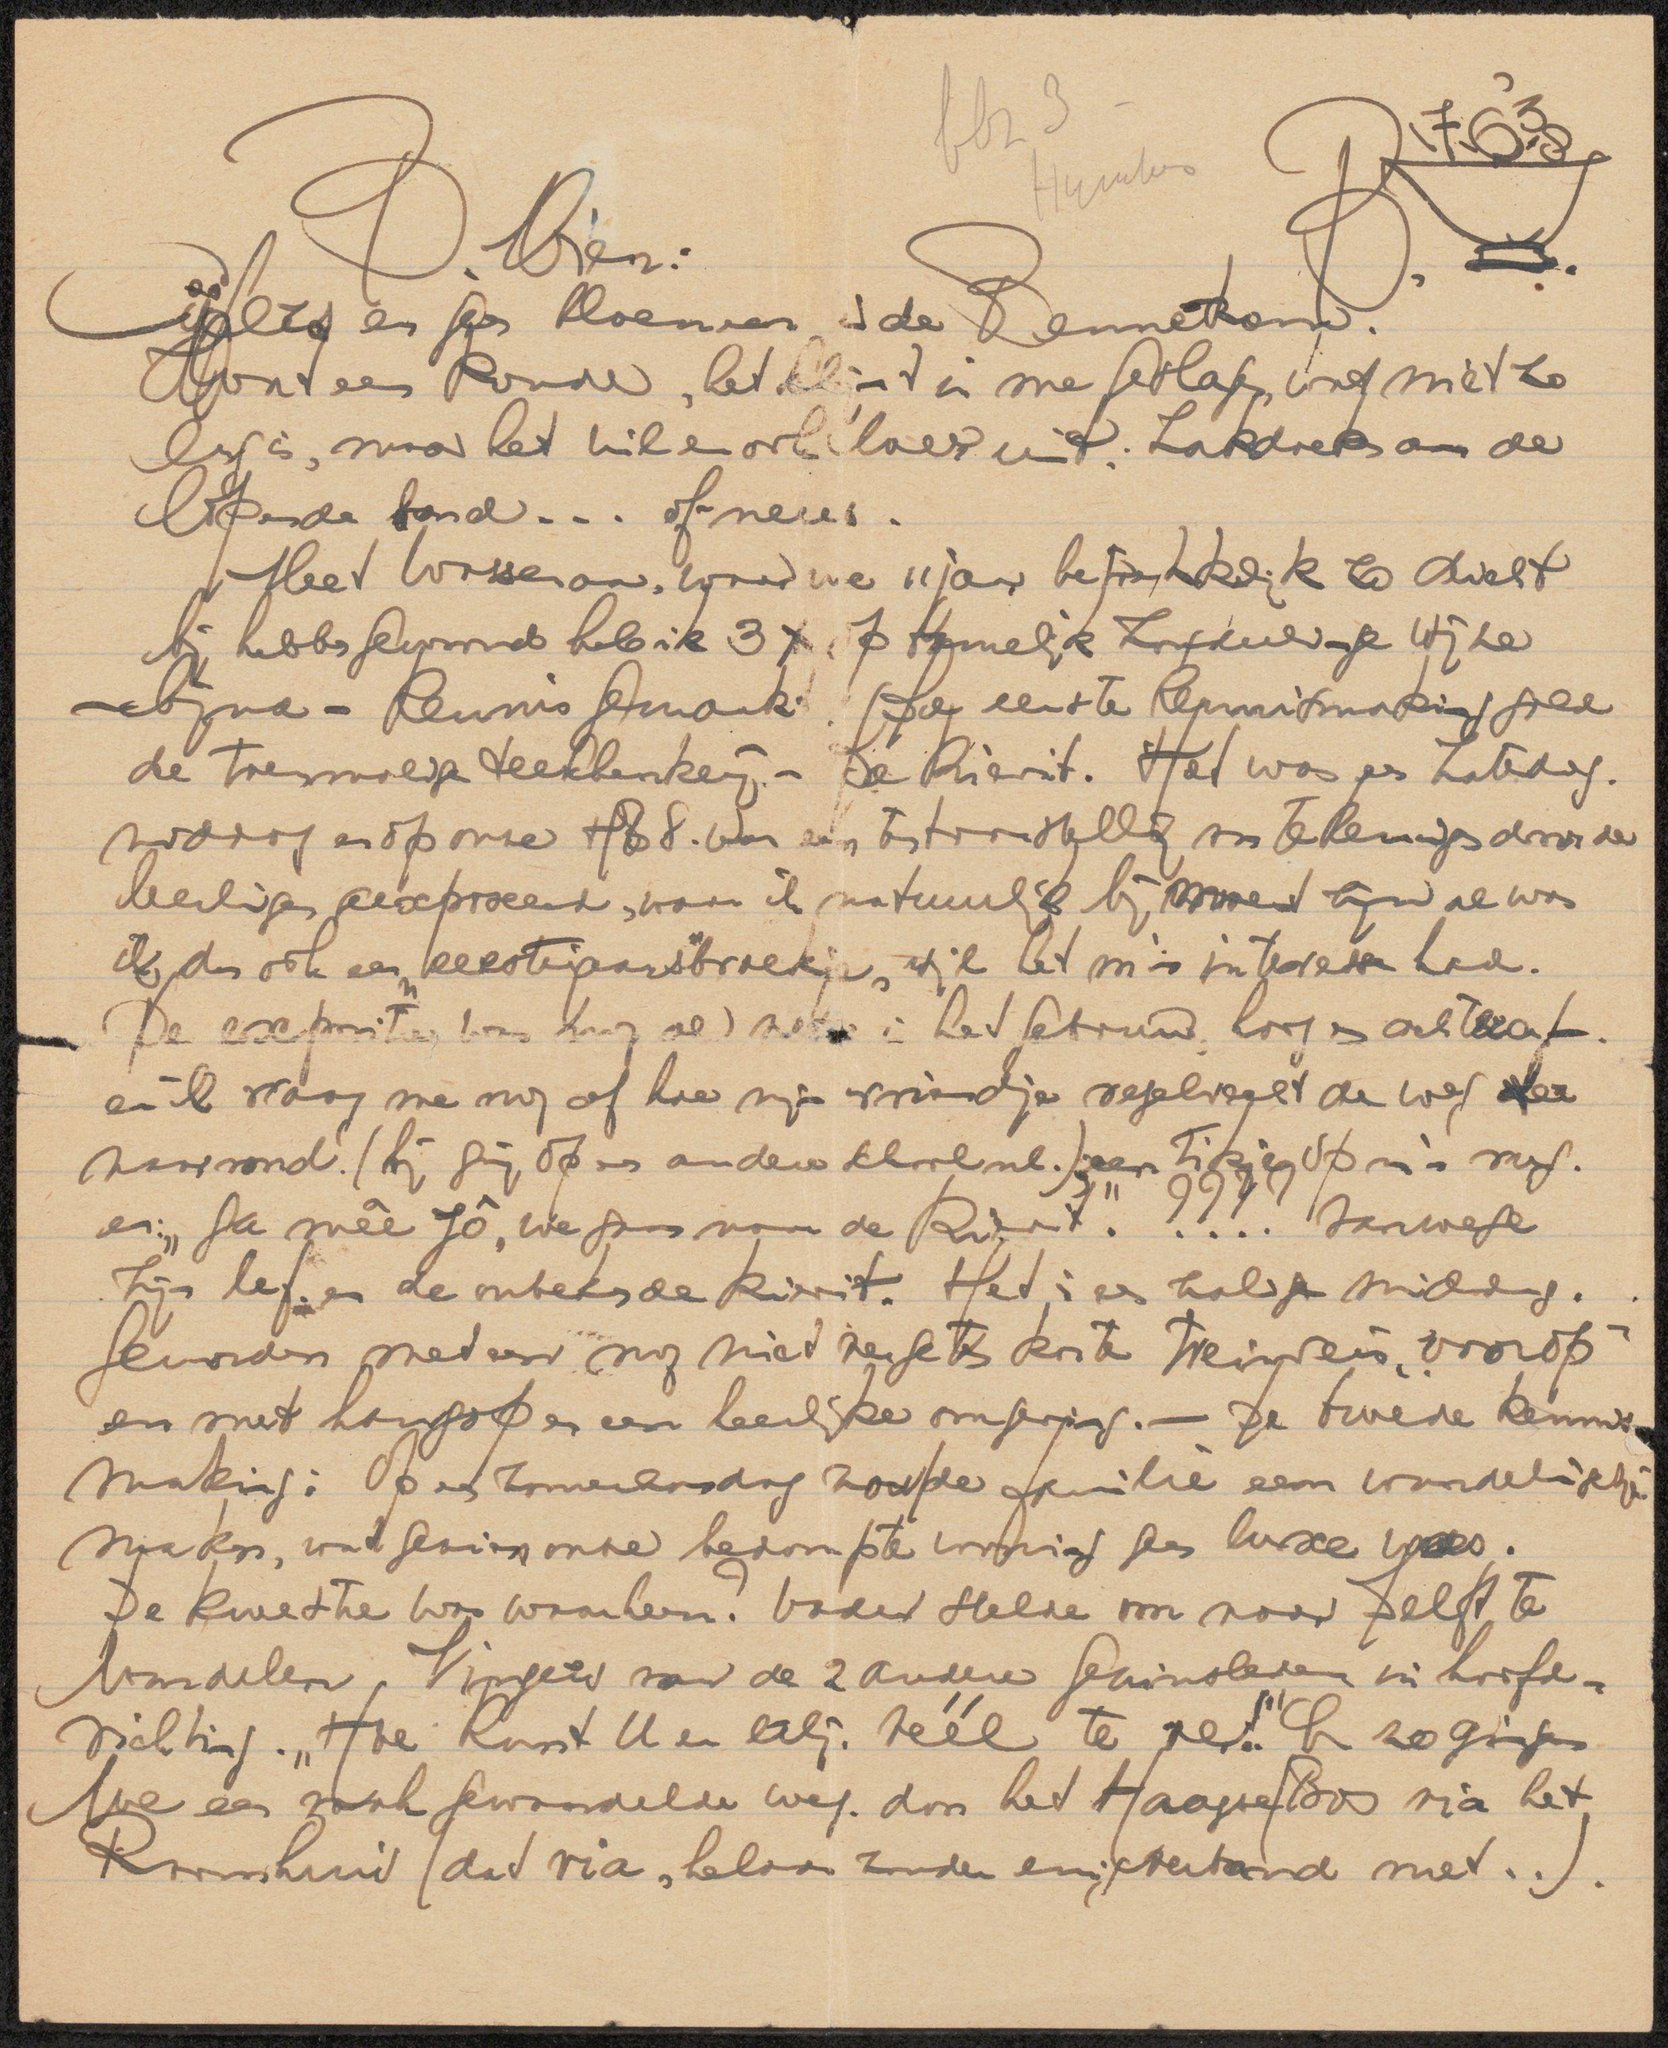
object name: letter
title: Brief aan Mien Cambier van Nooten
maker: dick ket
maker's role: draughtsman, print maker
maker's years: 1902-1940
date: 1938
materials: ink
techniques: pen, writing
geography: bennekom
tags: arnhem, mien cambier van nooten, chris huidekooper, education, tuition of the artist (in general), painting (including book-illumination, miniature-painting)